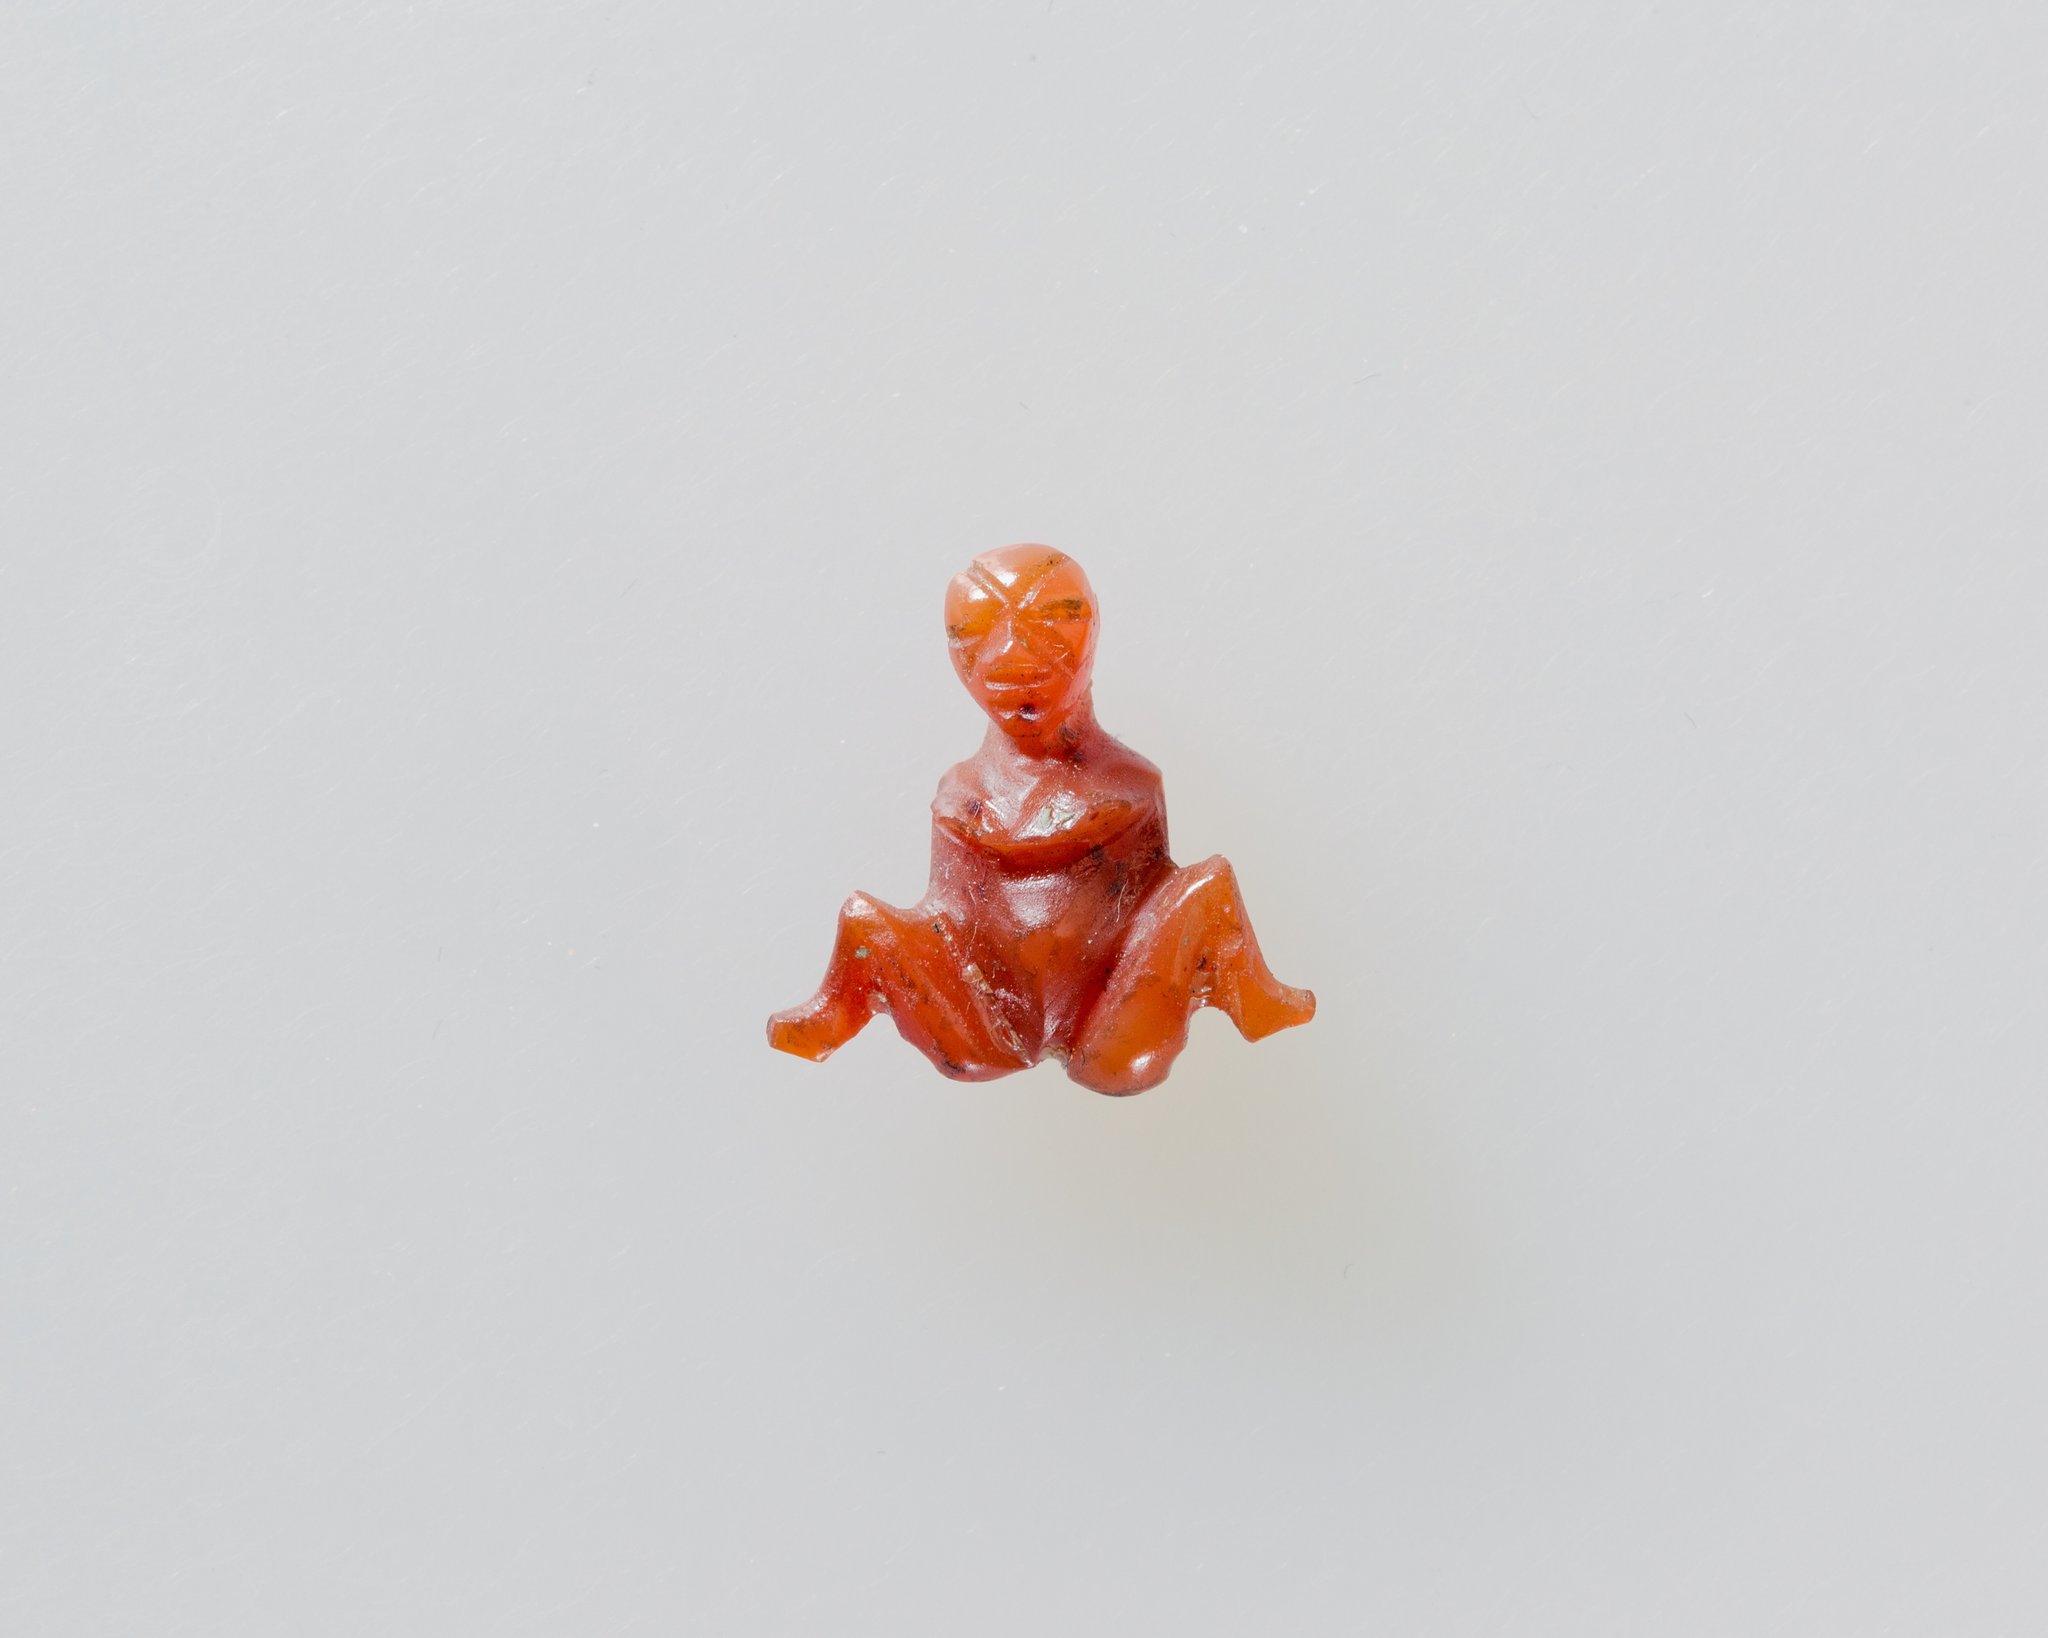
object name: amulet, omphale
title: Omphale figure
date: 100 BCE-300 CE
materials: gemstone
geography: egypt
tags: women